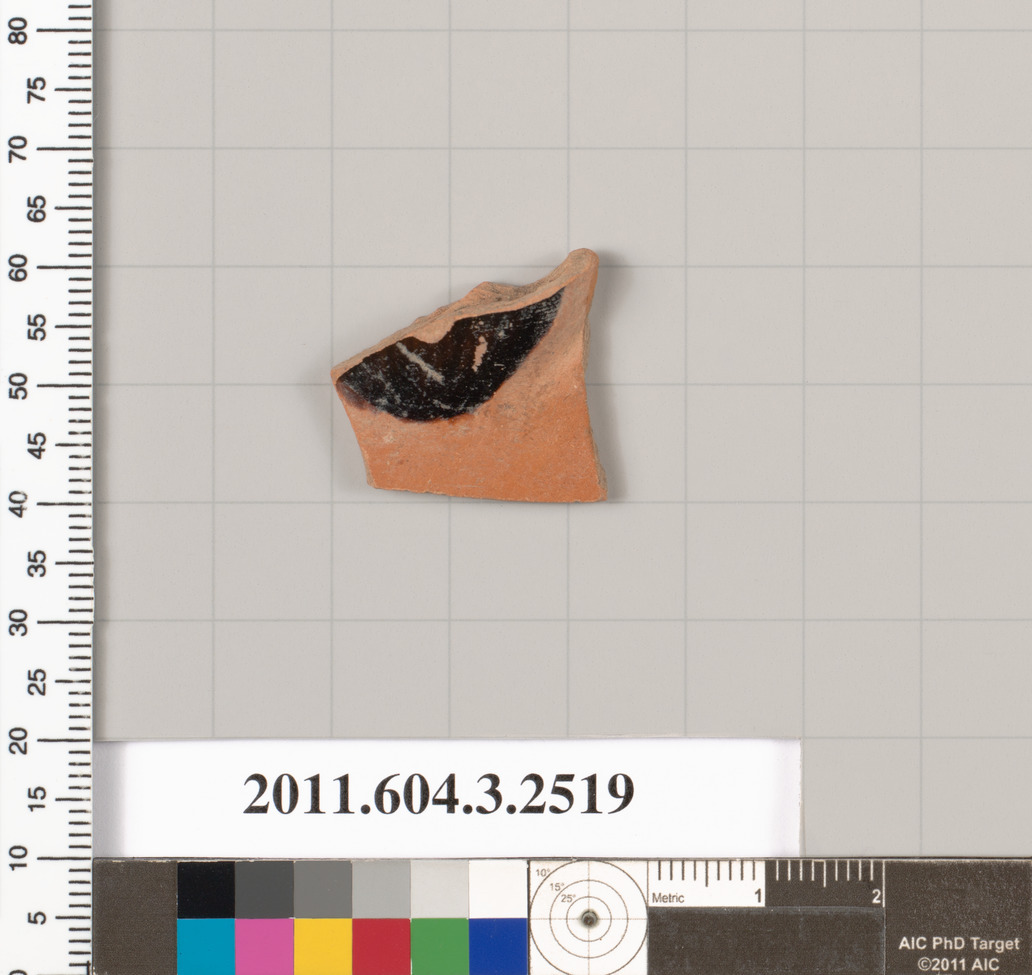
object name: kylix fragment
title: Terracotta fragment of a kylix (drinking cup)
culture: greek, attic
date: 600-401 BCE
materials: terracotta